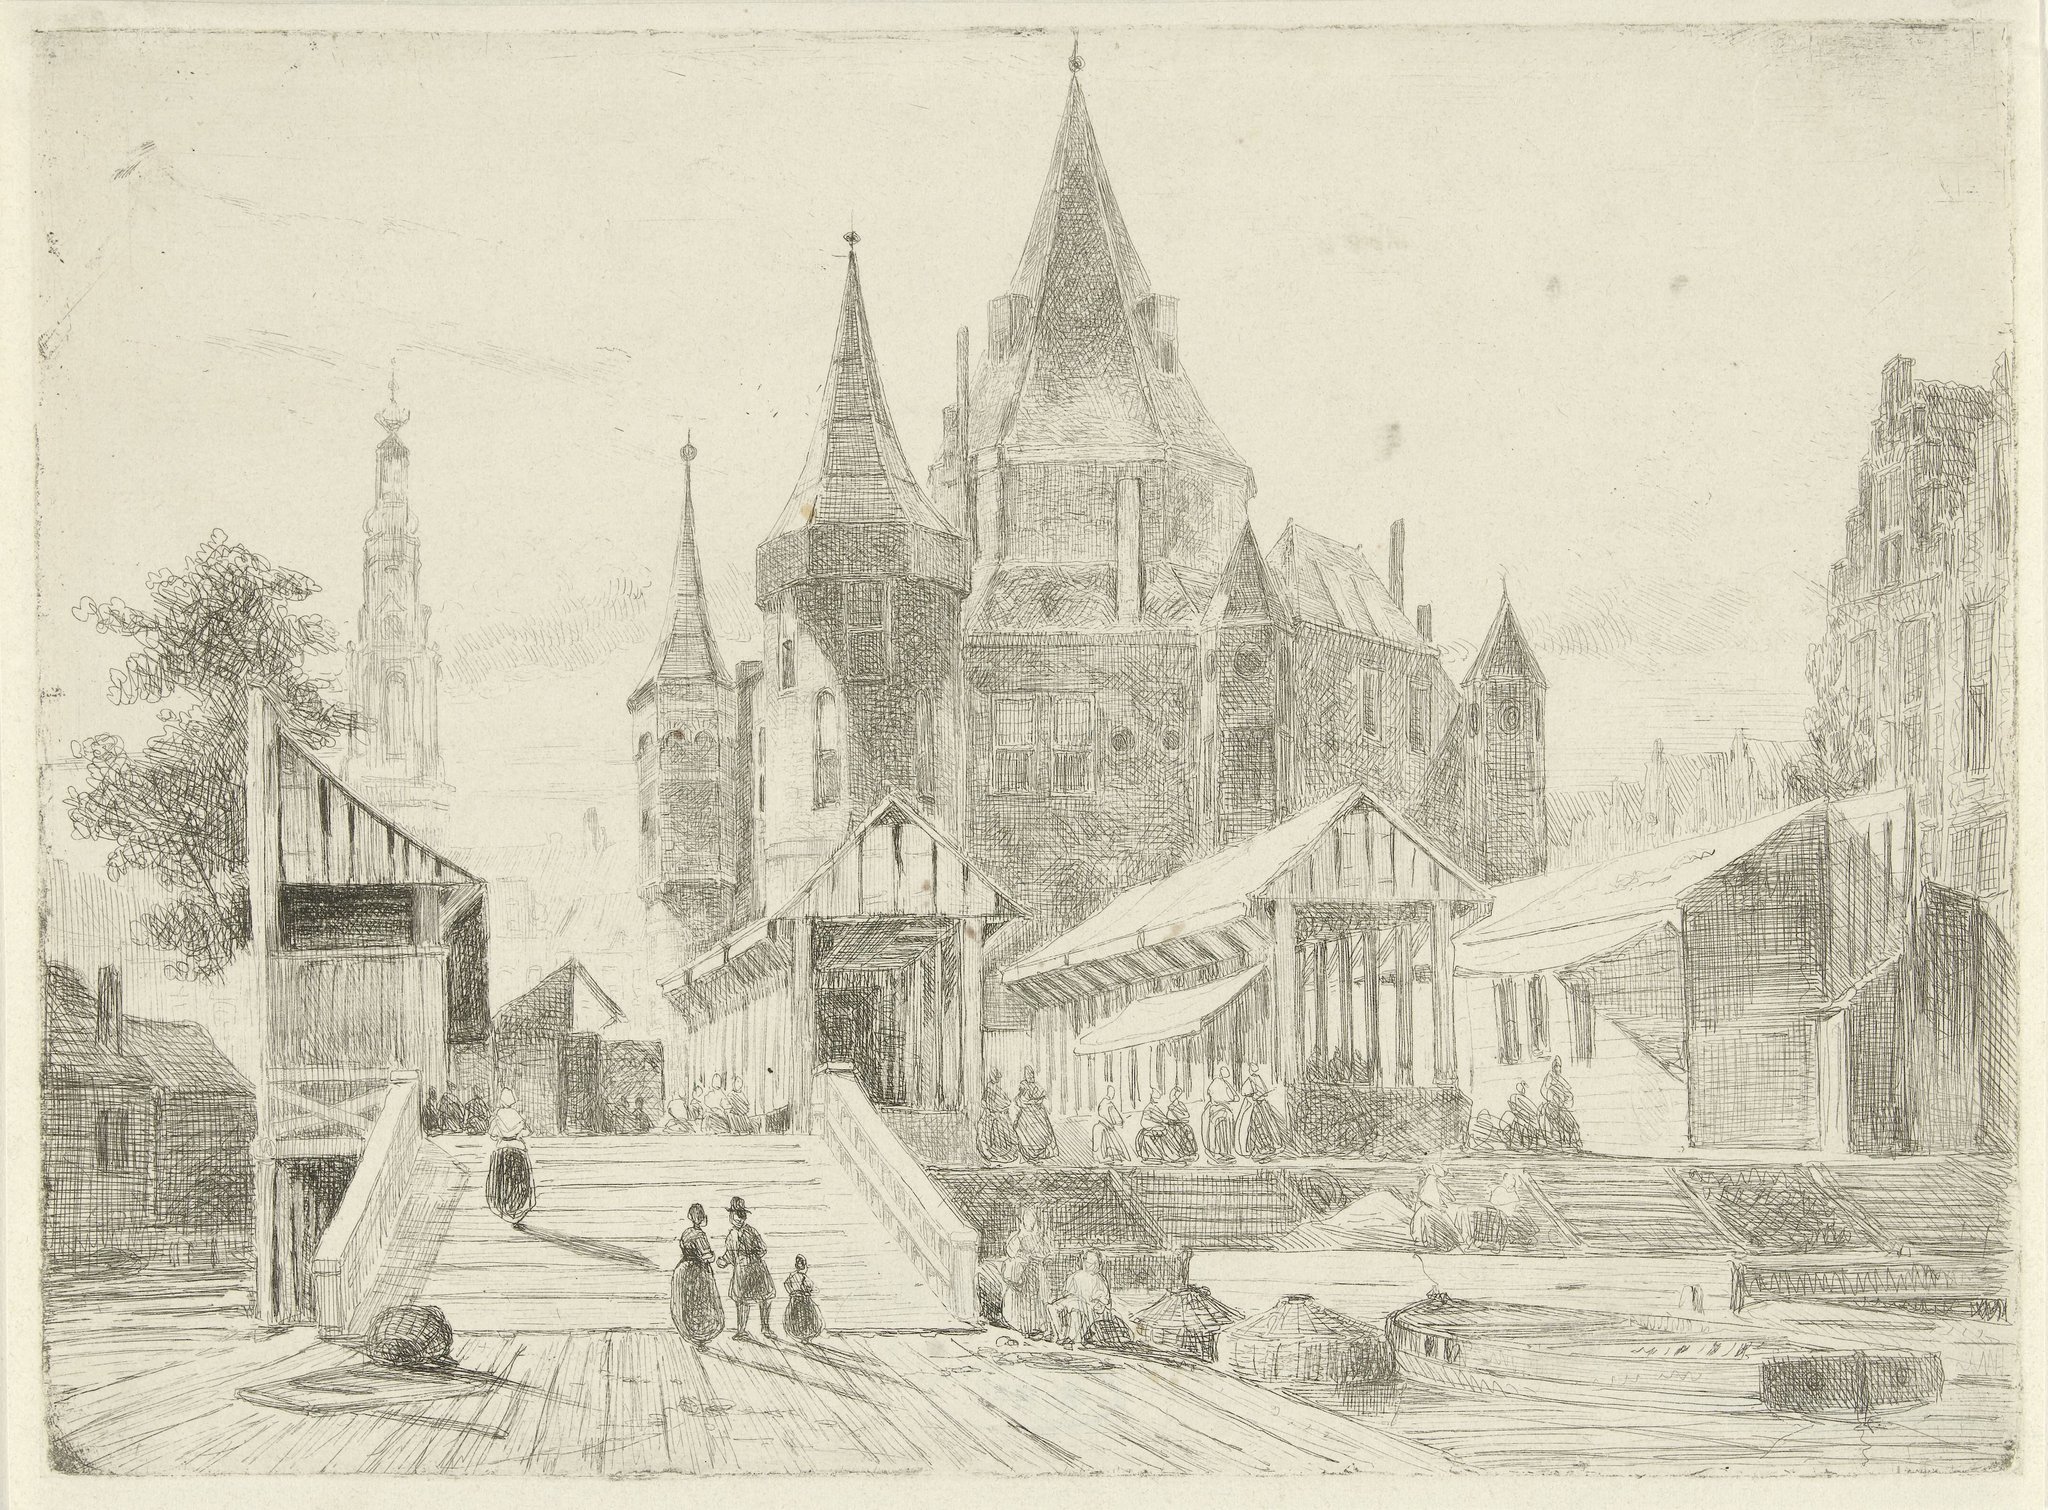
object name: print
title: Gezicht op de Nieuwmarkt te Amsterdam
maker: lambertus hardenberg (1822-1900)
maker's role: draughtsman, painter, print maker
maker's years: 1822-1900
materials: paper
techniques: etching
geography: the hague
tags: market, bridge, weigh-house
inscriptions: collector's mark: Lugt 2228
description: Gezicht op de Nieuwmarkt in Amsterdam, met op de voorgrond figuren bij een houten brug en markthallen, op de achtergrond de Waag of de St. Anthonispoort en de toren van de Zuiderkerk.